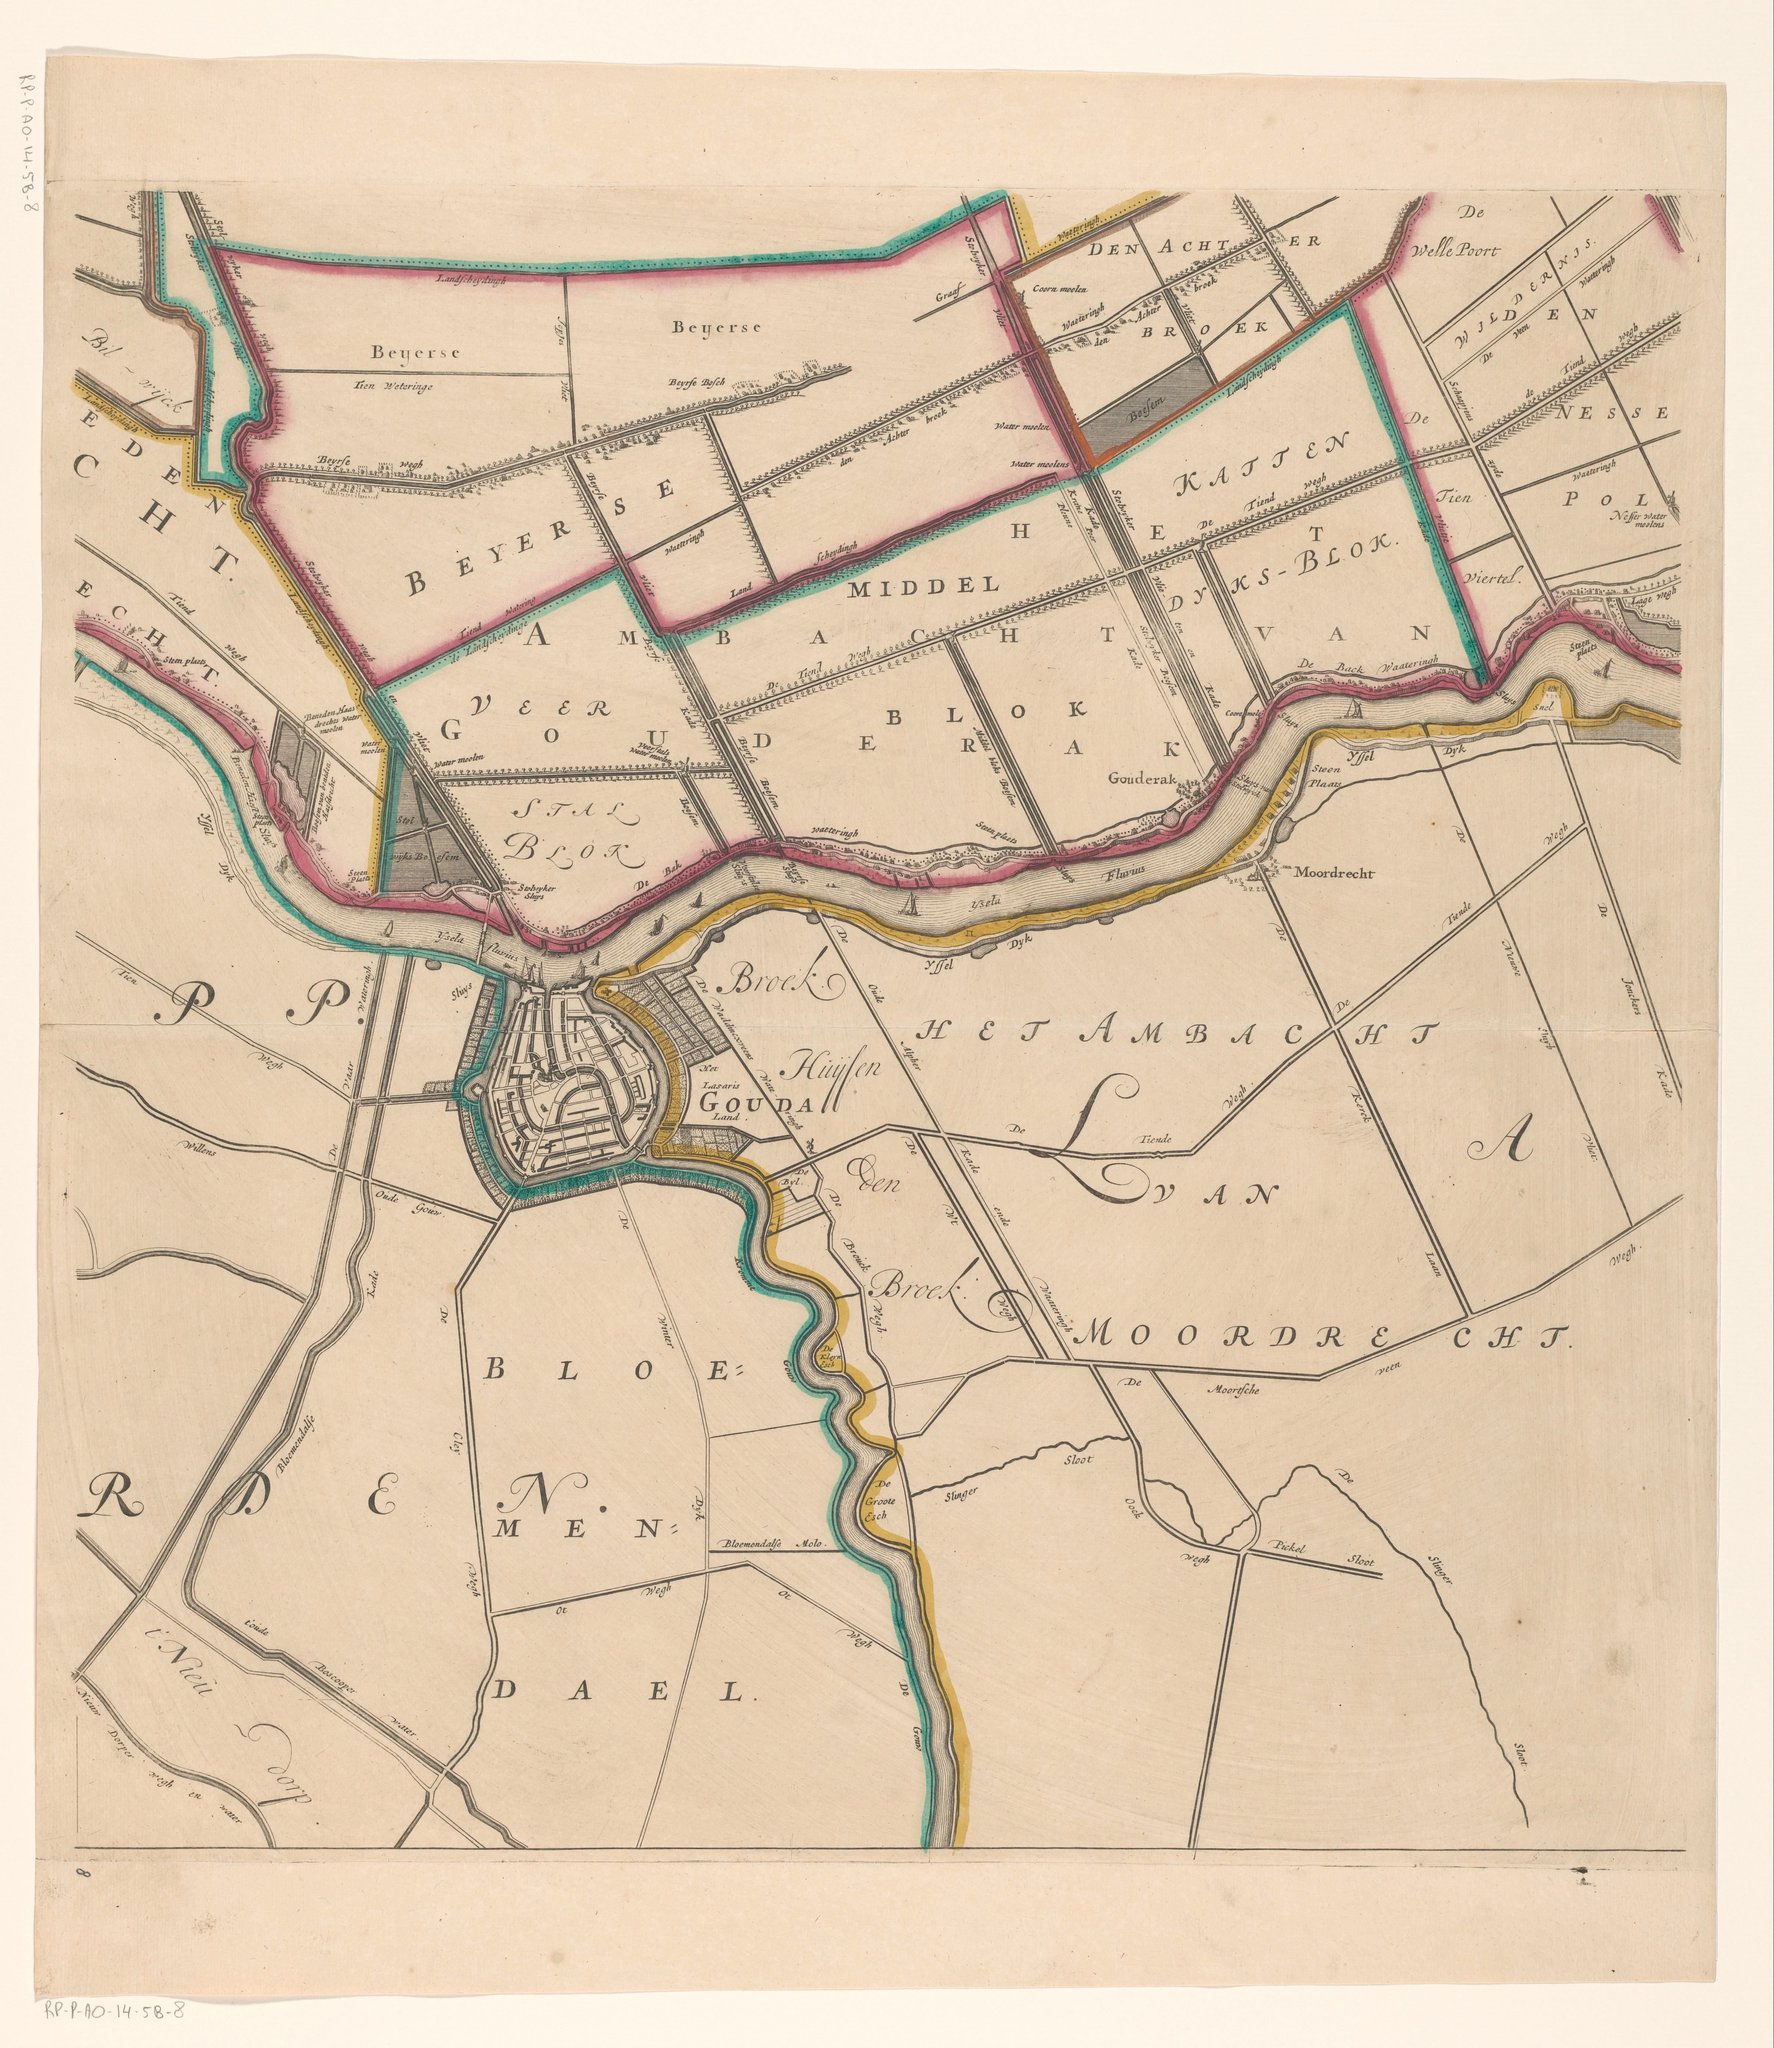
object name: print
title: Kaart van het Hoogheemraadschap van de Krimpenerwaard (vijfde deel van kaart)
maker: johannes leupenius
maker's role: draughtsman, painter, print maker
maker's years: 1646-1693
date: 1683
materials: paper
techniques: engraving, etching, hand coloring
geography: amsterdam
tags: maps of separate countries or regions, maps of cities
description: Vijfde deel van de kaart van de eerste druk van 'Het Hooge Heemraadschap vande Crimpenre Waard', een wandkaart (bestaande uit een zesdelige kaart en een wapenrand) van het Hoogheemraadschap van de Krimpenerwaard.